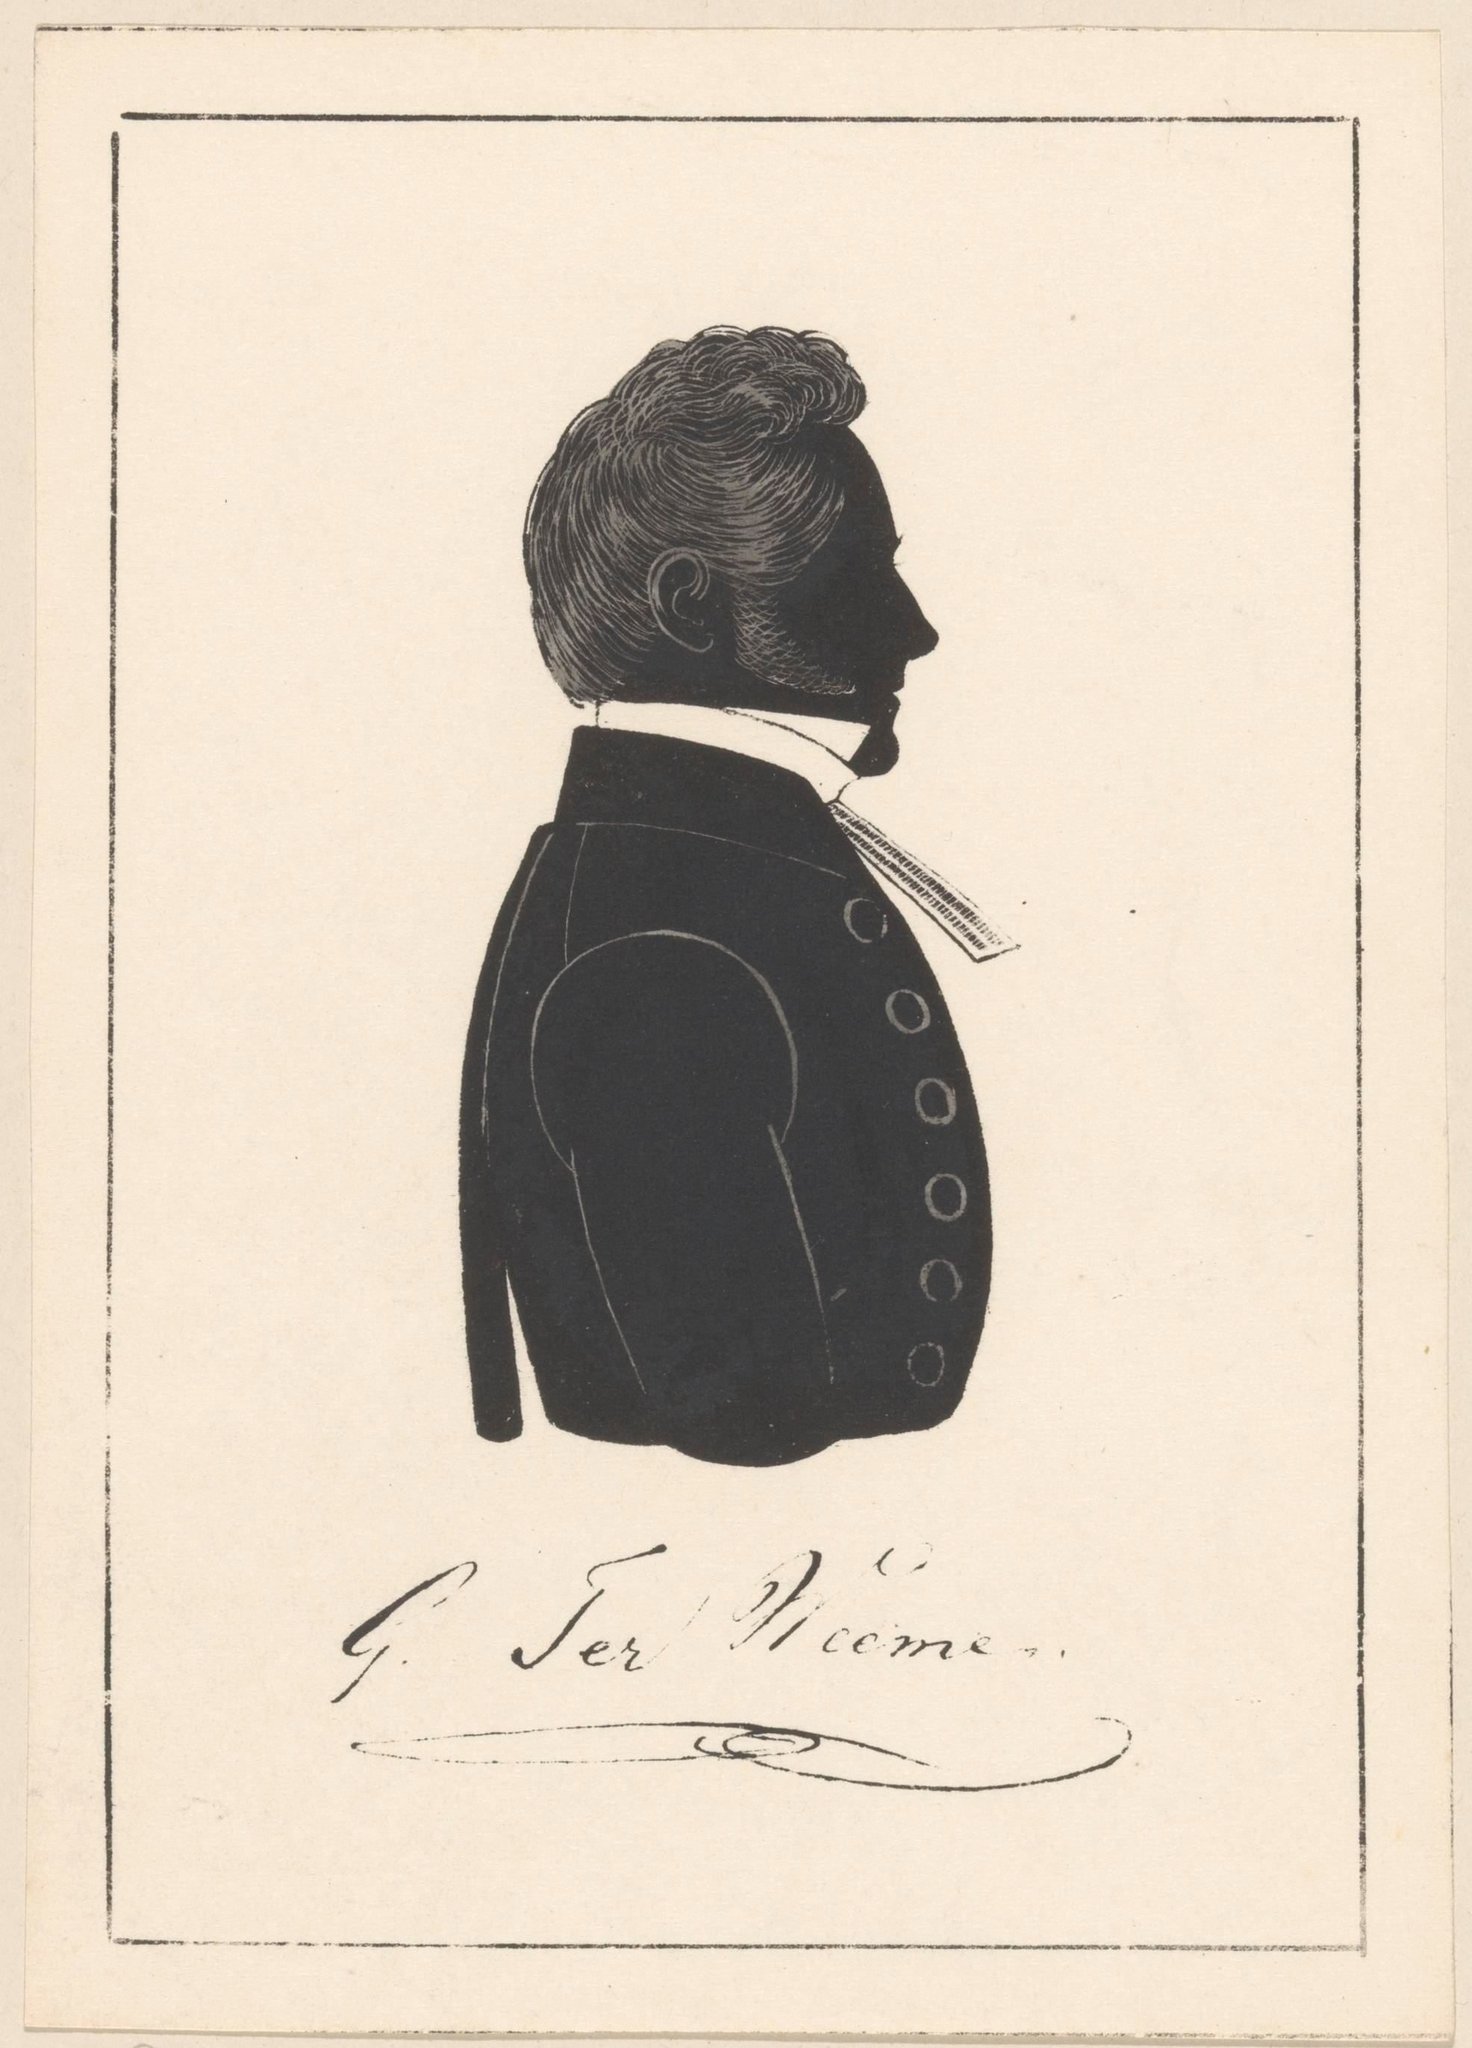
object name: print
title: Silhouetportret van G. ter Weemen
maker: pieter barbiers (iv)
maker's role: painter, print maker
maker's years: 1798-1848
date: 1809-1848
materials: paper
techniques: hand coloring, lithograph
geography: netherlands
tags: historical persons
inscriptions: collector's mark: Lugt 2228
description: Onder het portret de signatuur van de geportretteerde.